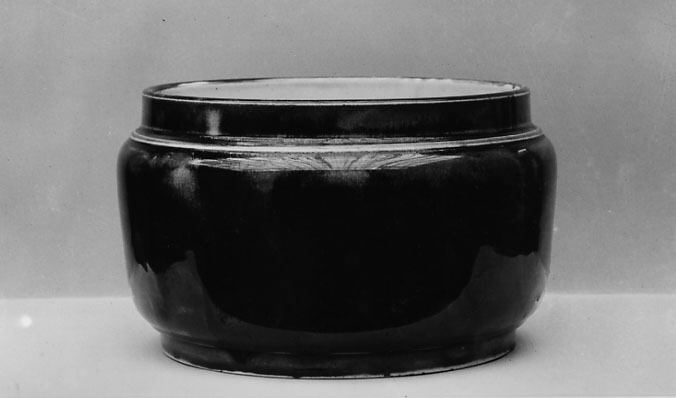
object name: jardinière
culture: french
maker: ernest chaplet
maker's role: designer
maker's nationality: french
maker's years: 1835-1909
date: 1890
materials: porcelain